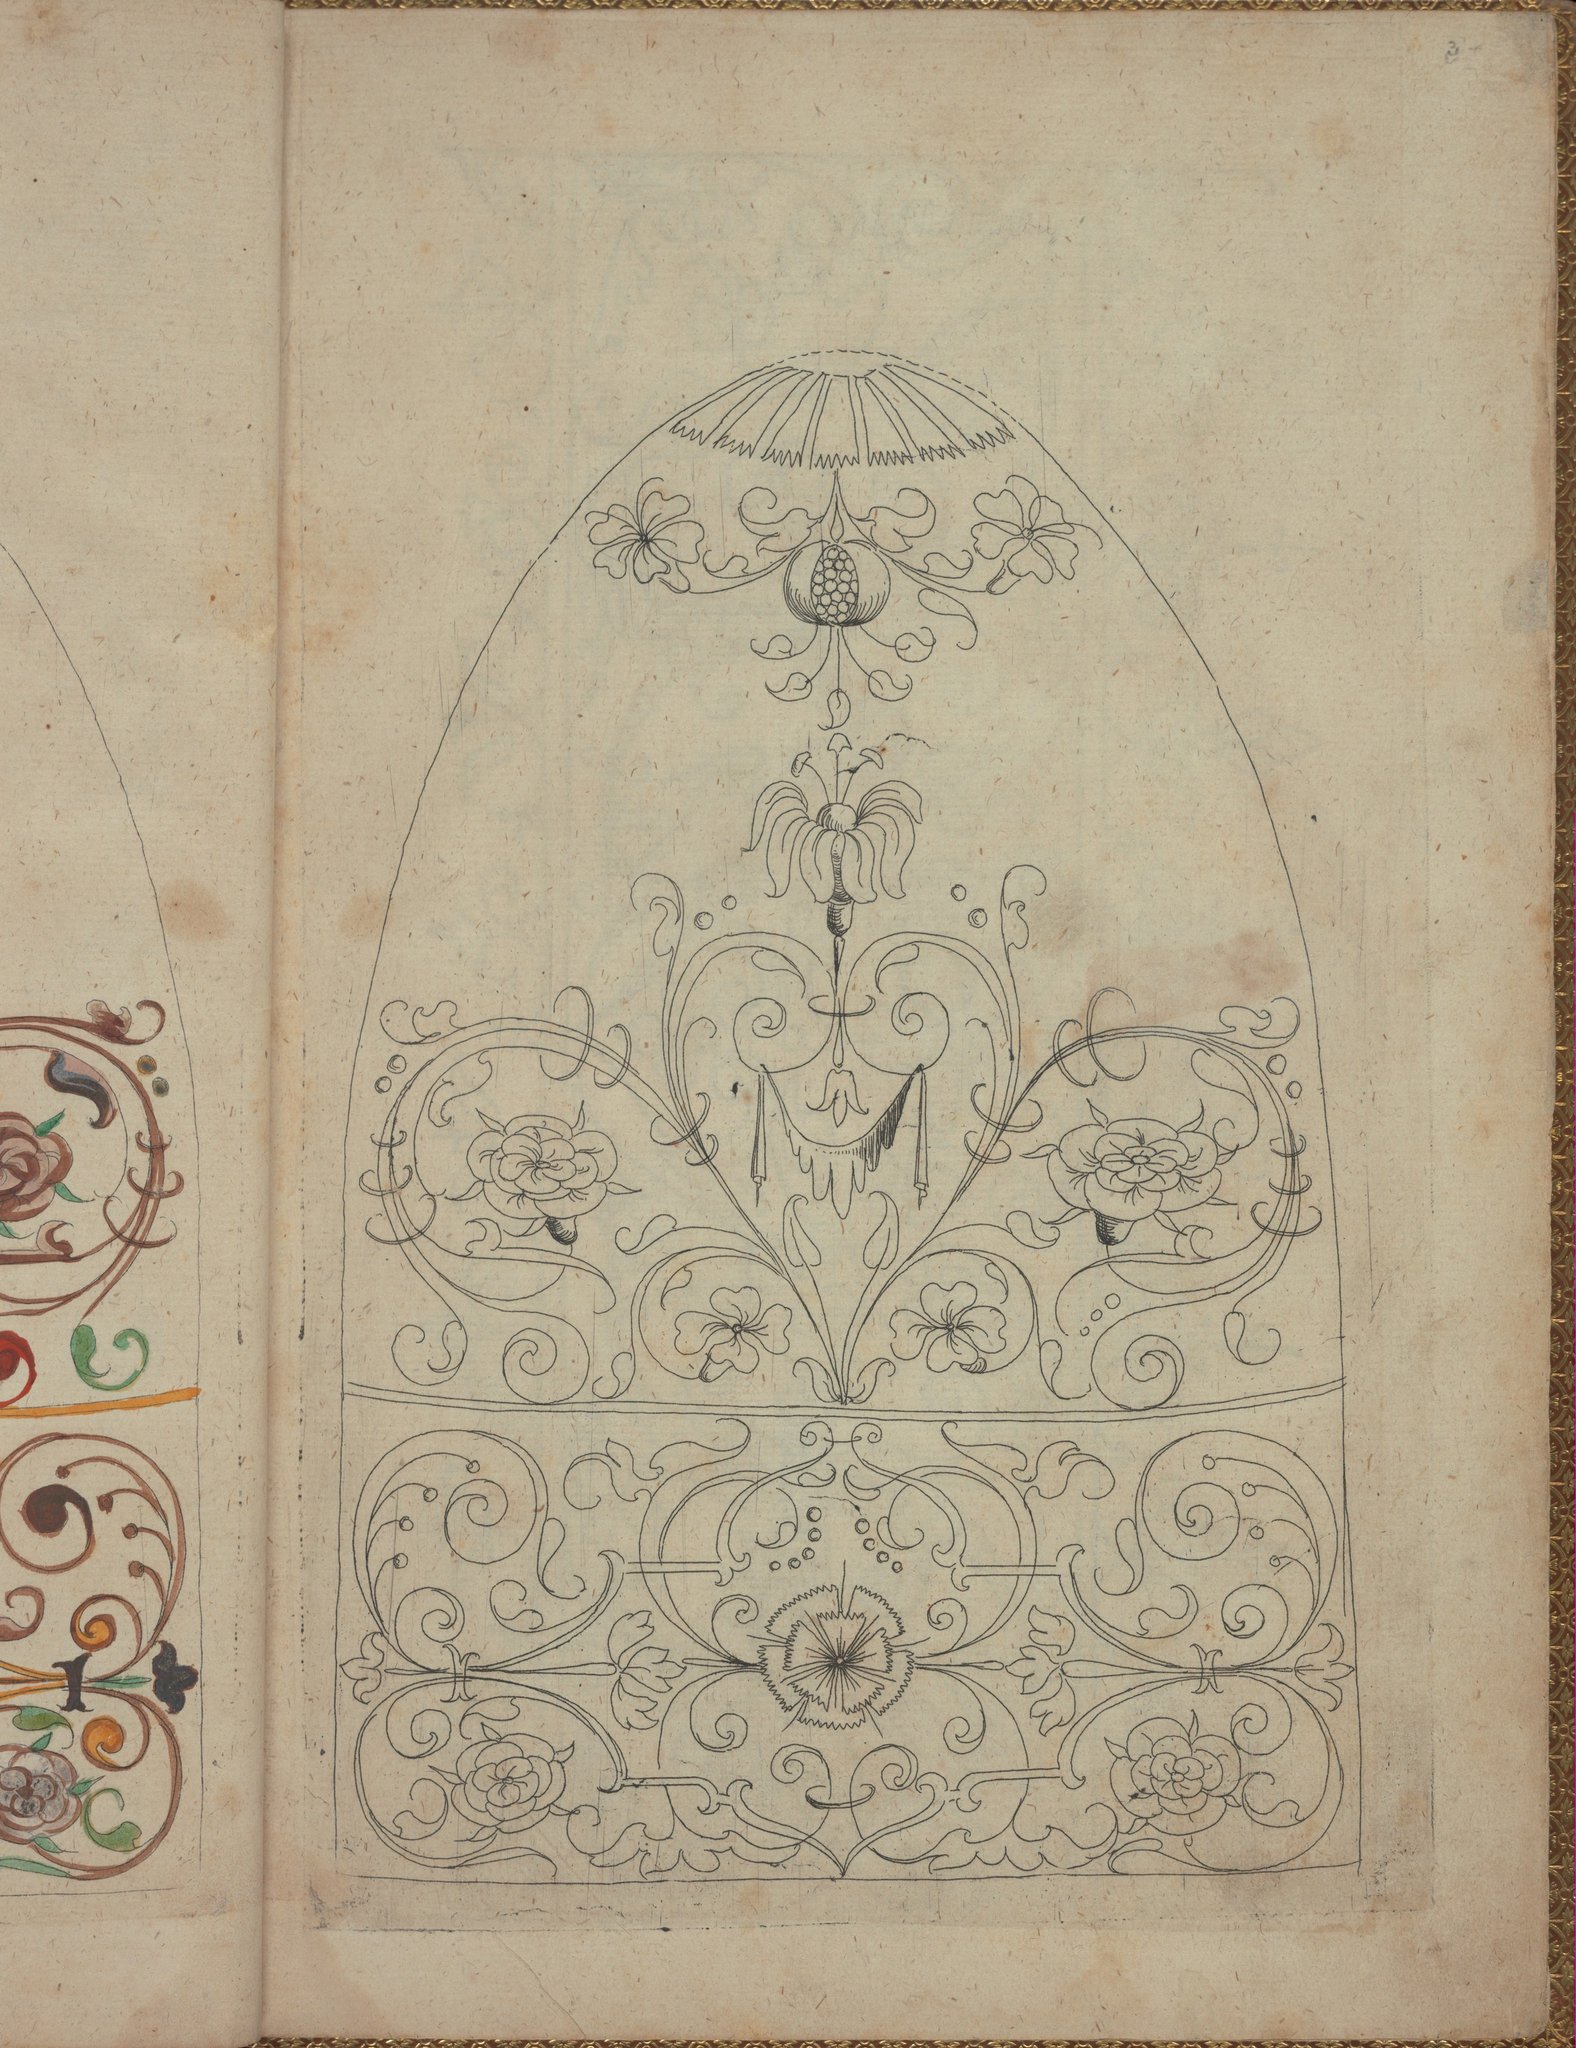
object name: book print ornament architecture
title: New Modelbüch (Page 3r)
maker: andreas bretschneider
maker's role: designer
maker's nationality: german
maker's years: 1573-1645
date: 1615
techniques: etching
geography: germany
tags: flowers